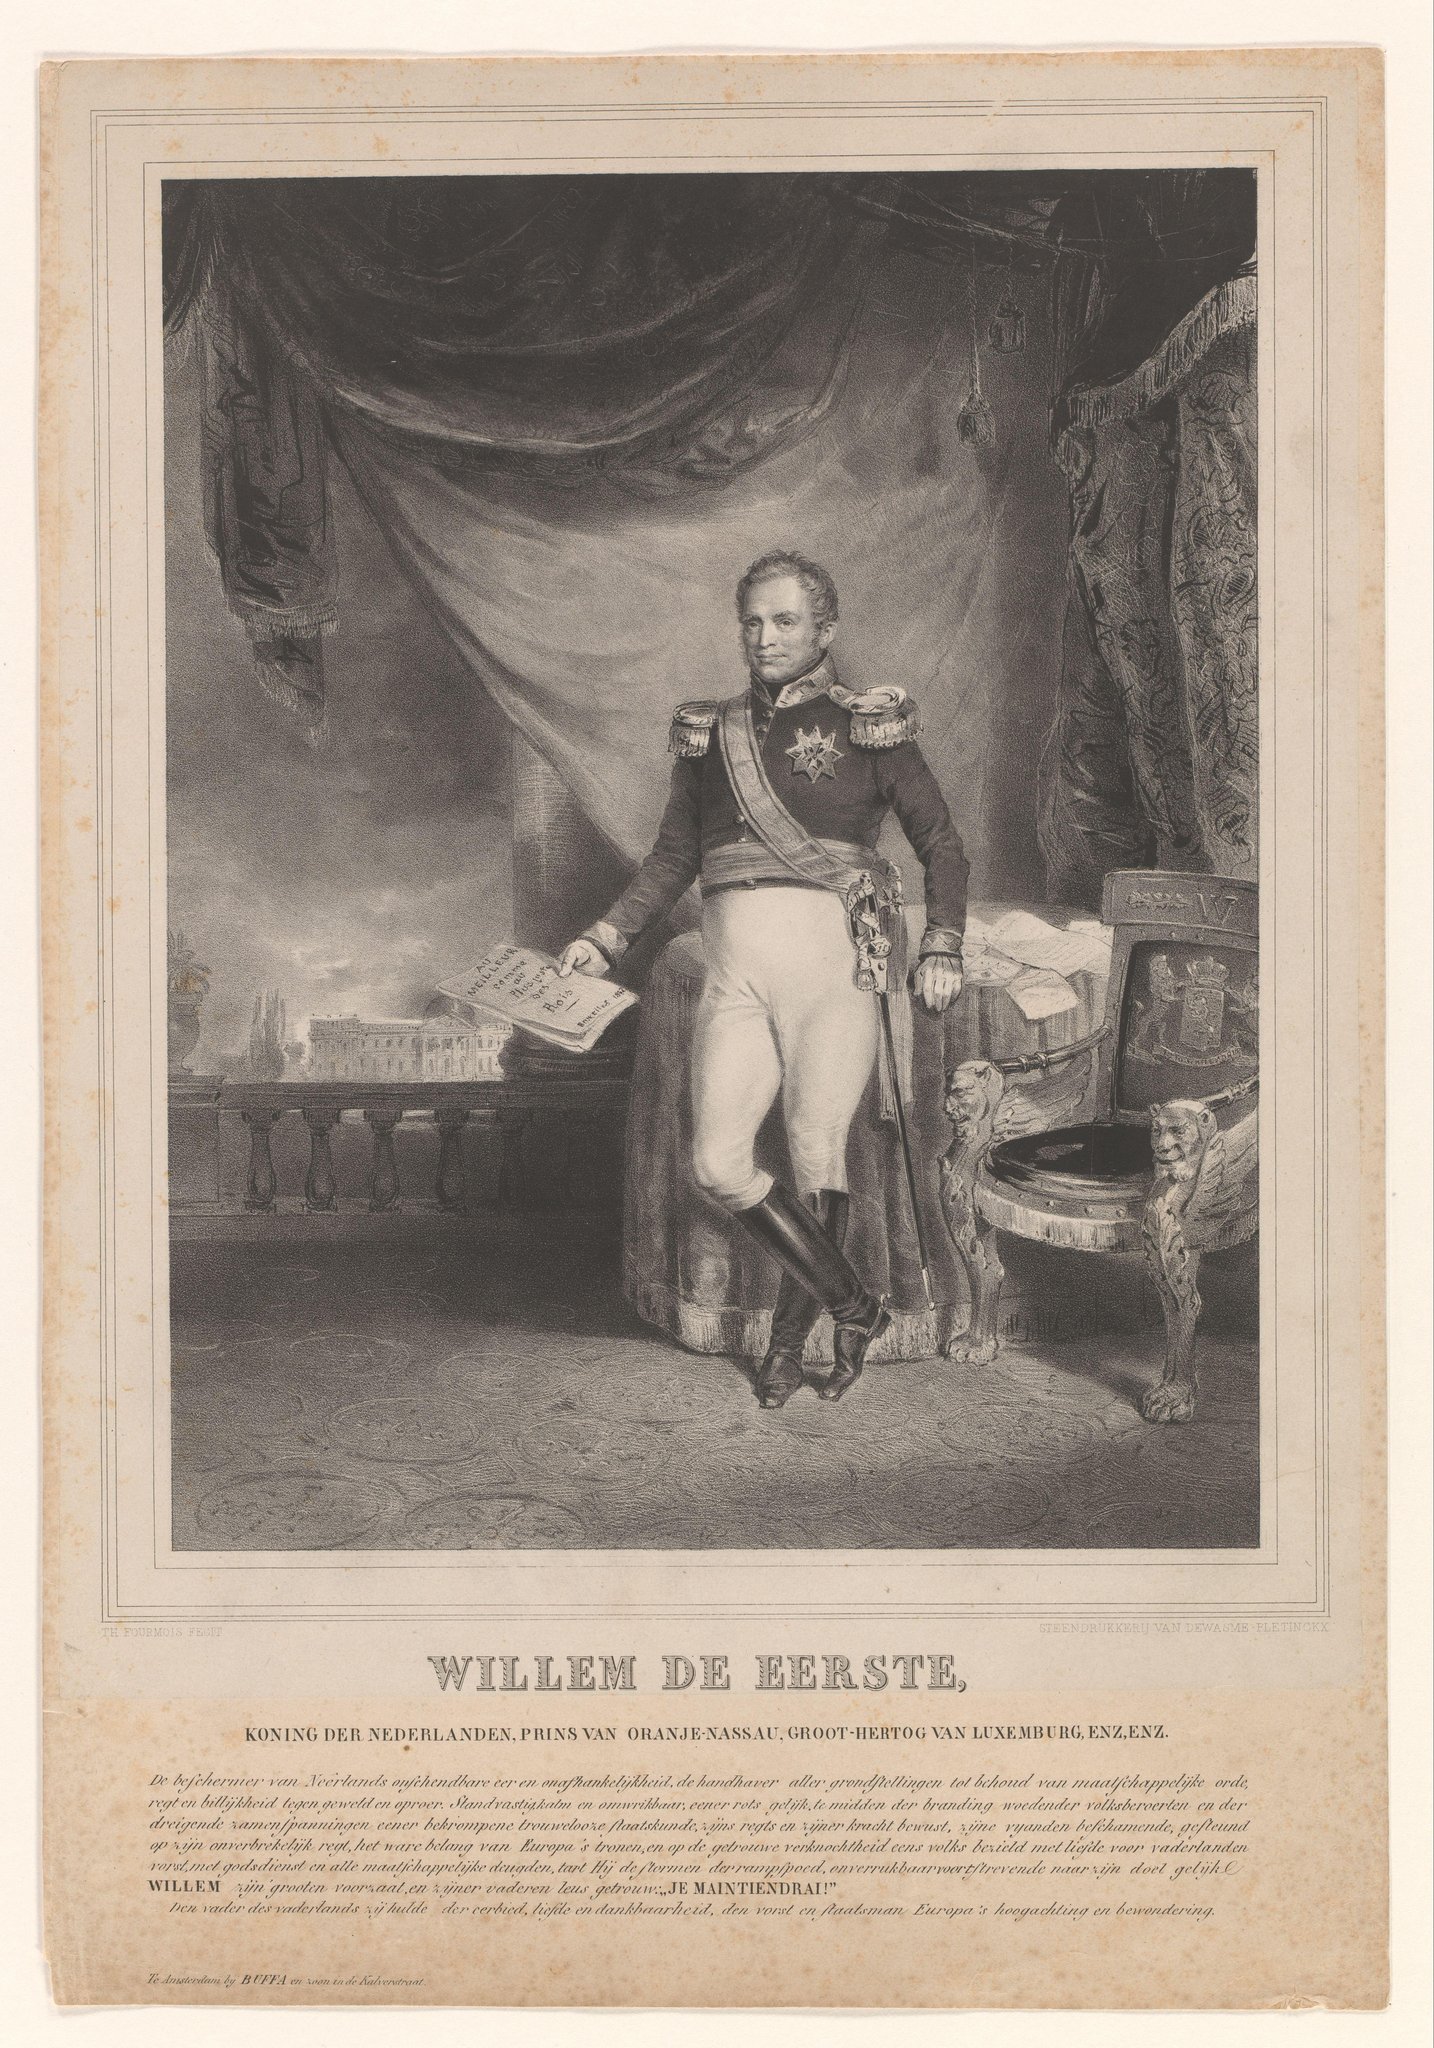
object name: print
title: Willem de eerste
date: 1827-1851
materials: paper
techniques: lithograph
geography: amsterdam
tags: the hague, berlin, william i of the netherlands, armchair, seat, historical persons, interior of the house, paper (writing material)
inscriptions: label: ‘3333a’